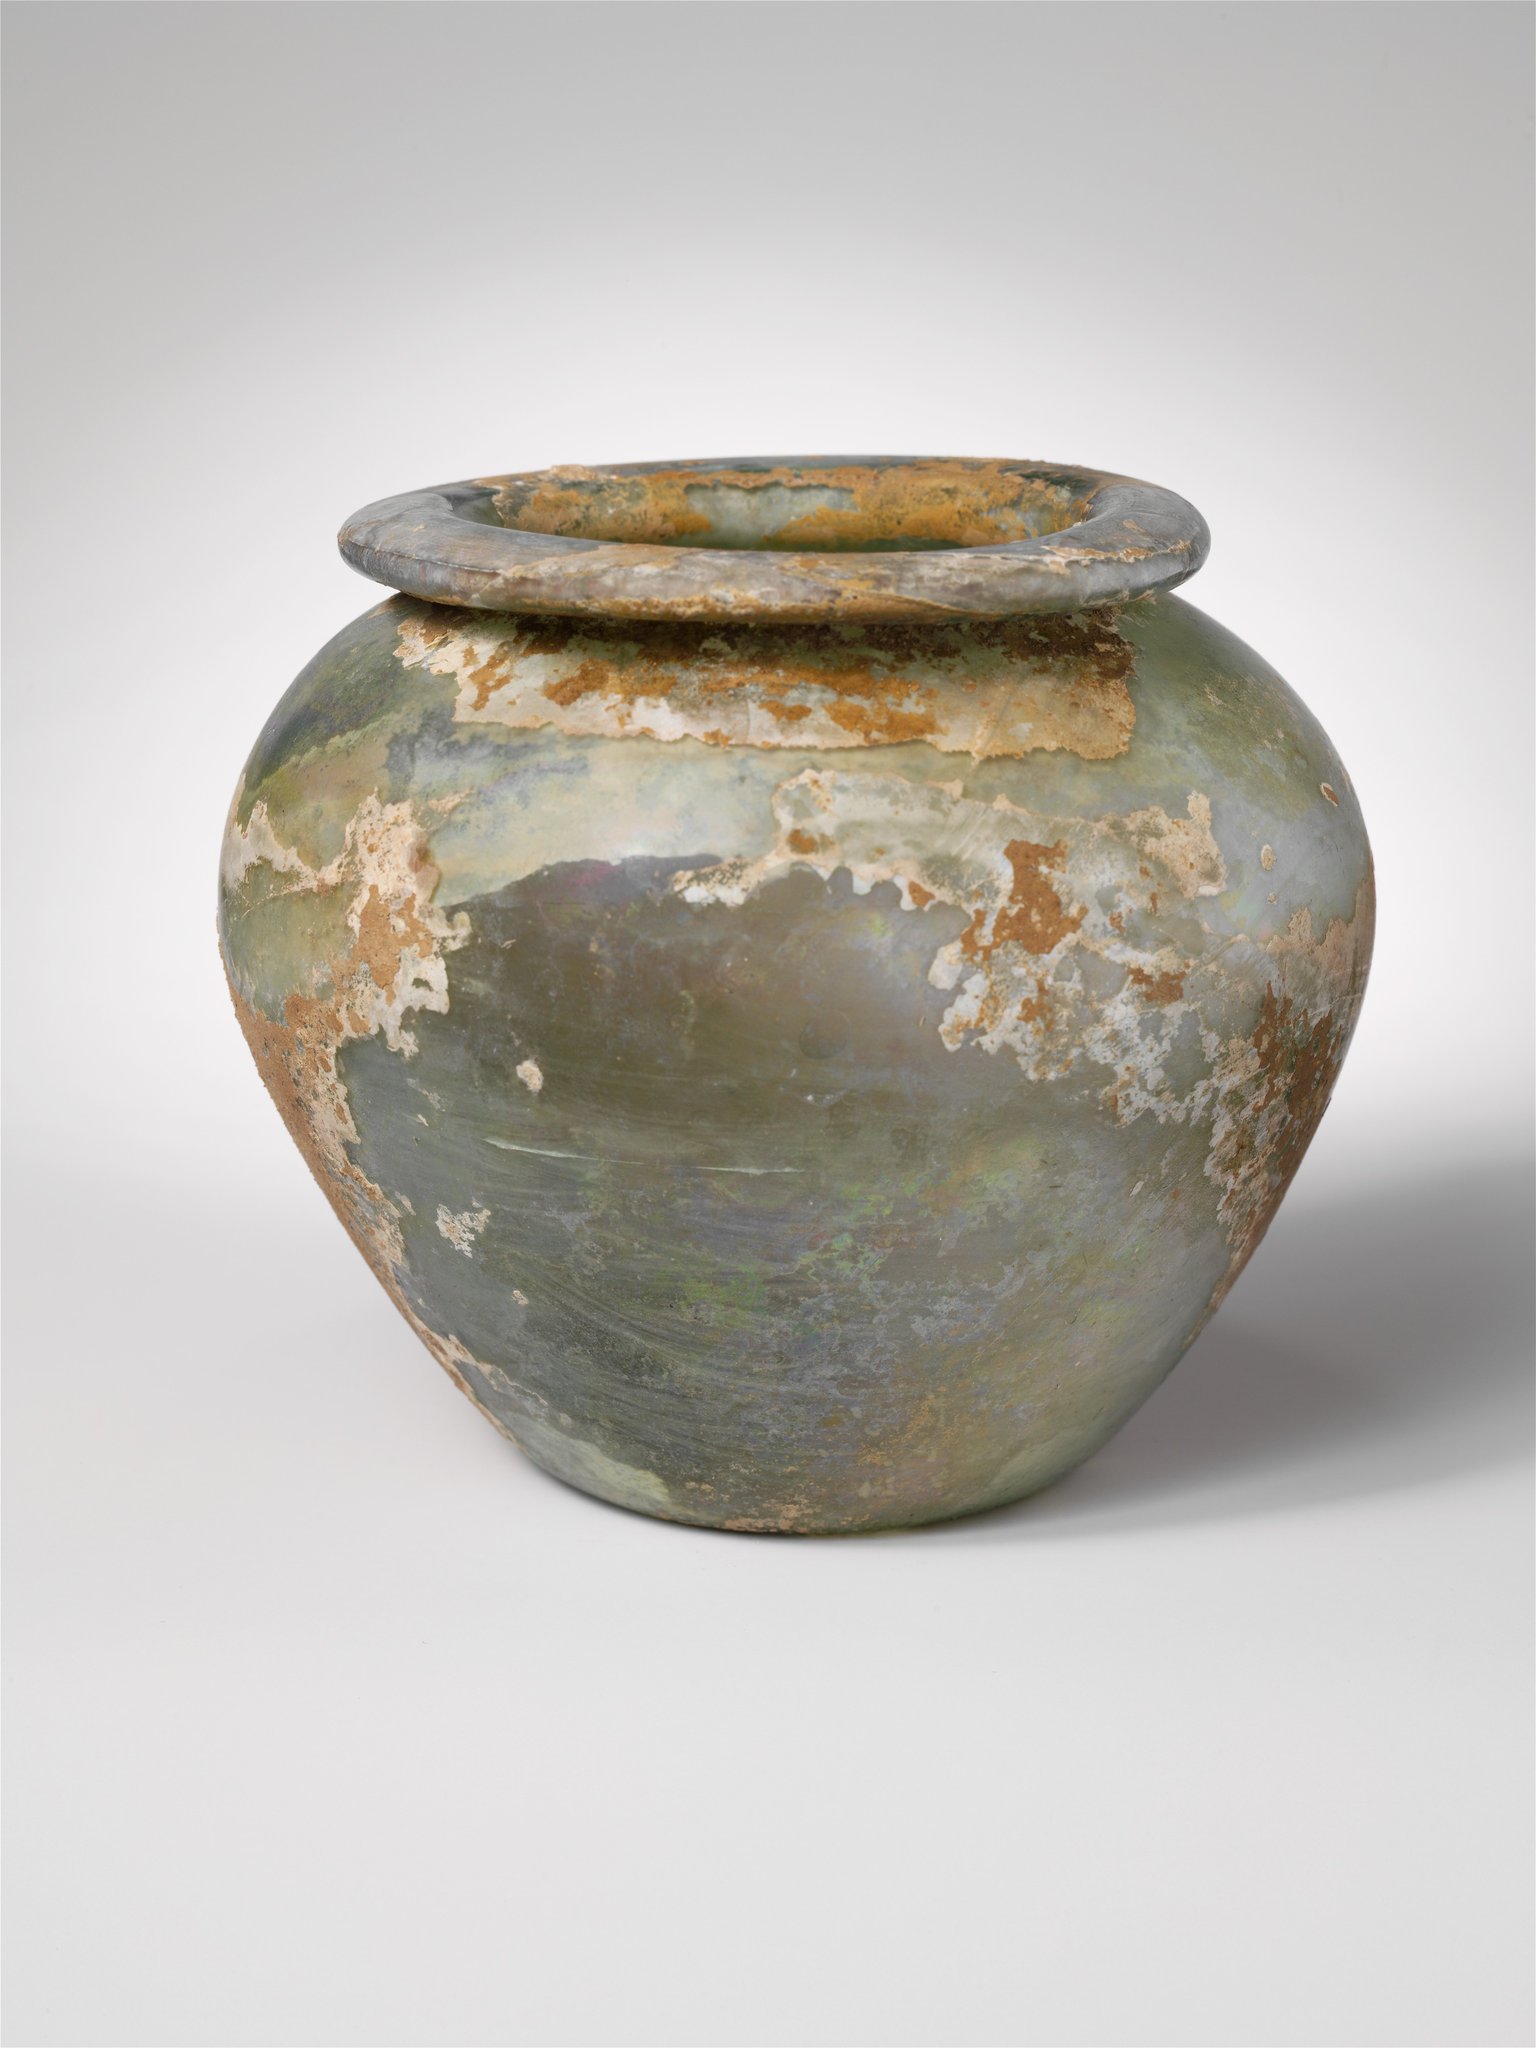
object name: jar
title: Glass jar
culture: roman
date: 34-200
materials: glass